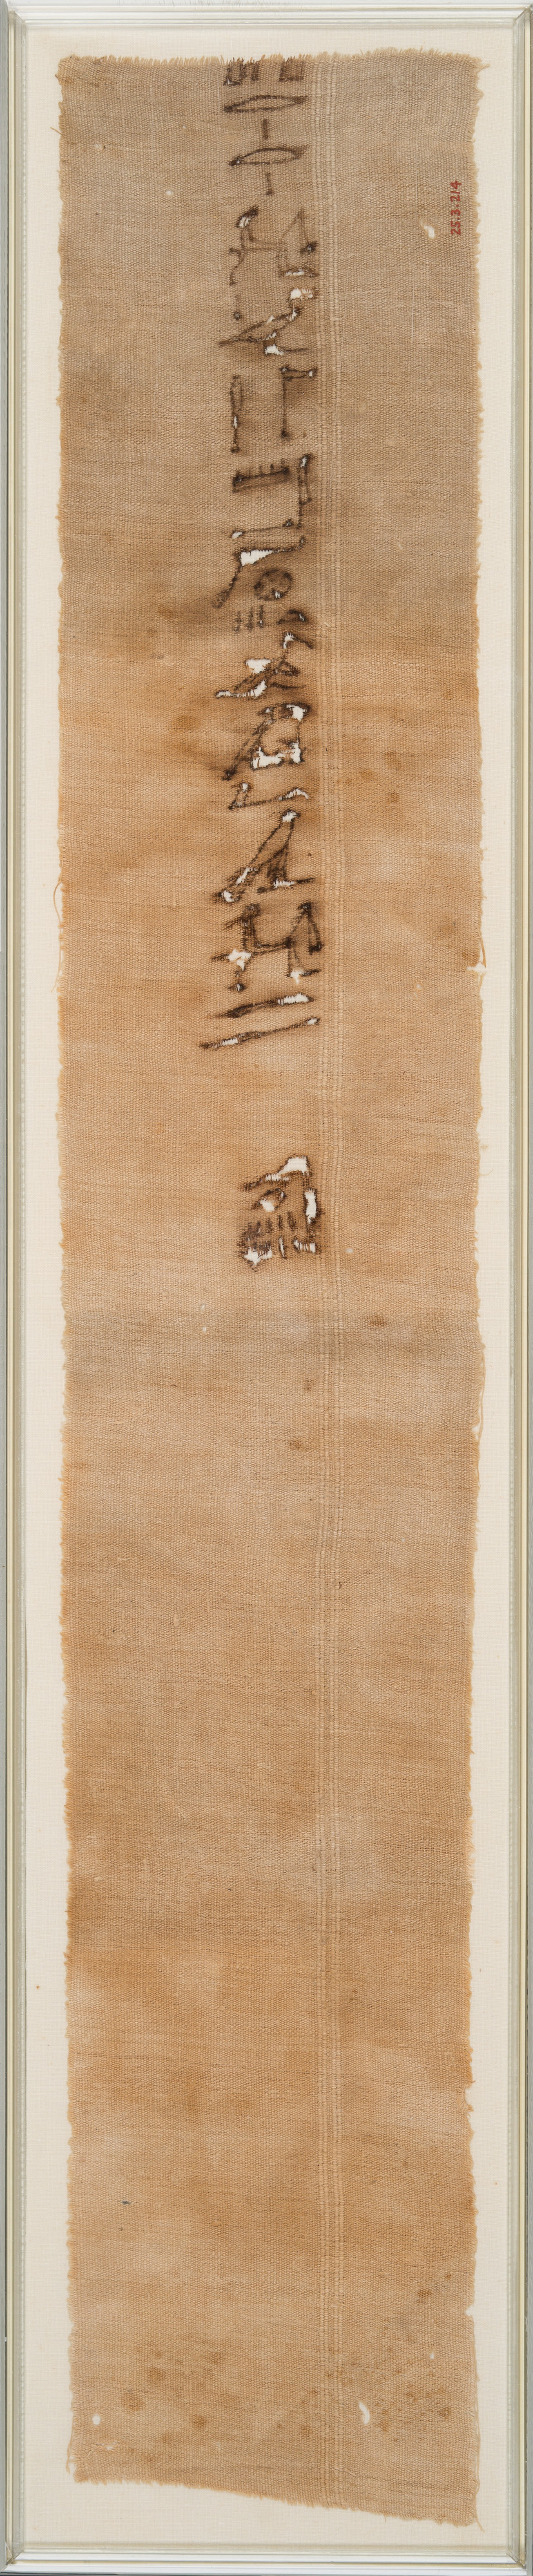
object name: bandage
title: Mummy Bandage Inscribed for Paherer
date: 750-700 BCE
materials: linen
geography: egypt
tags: hieroglyphs